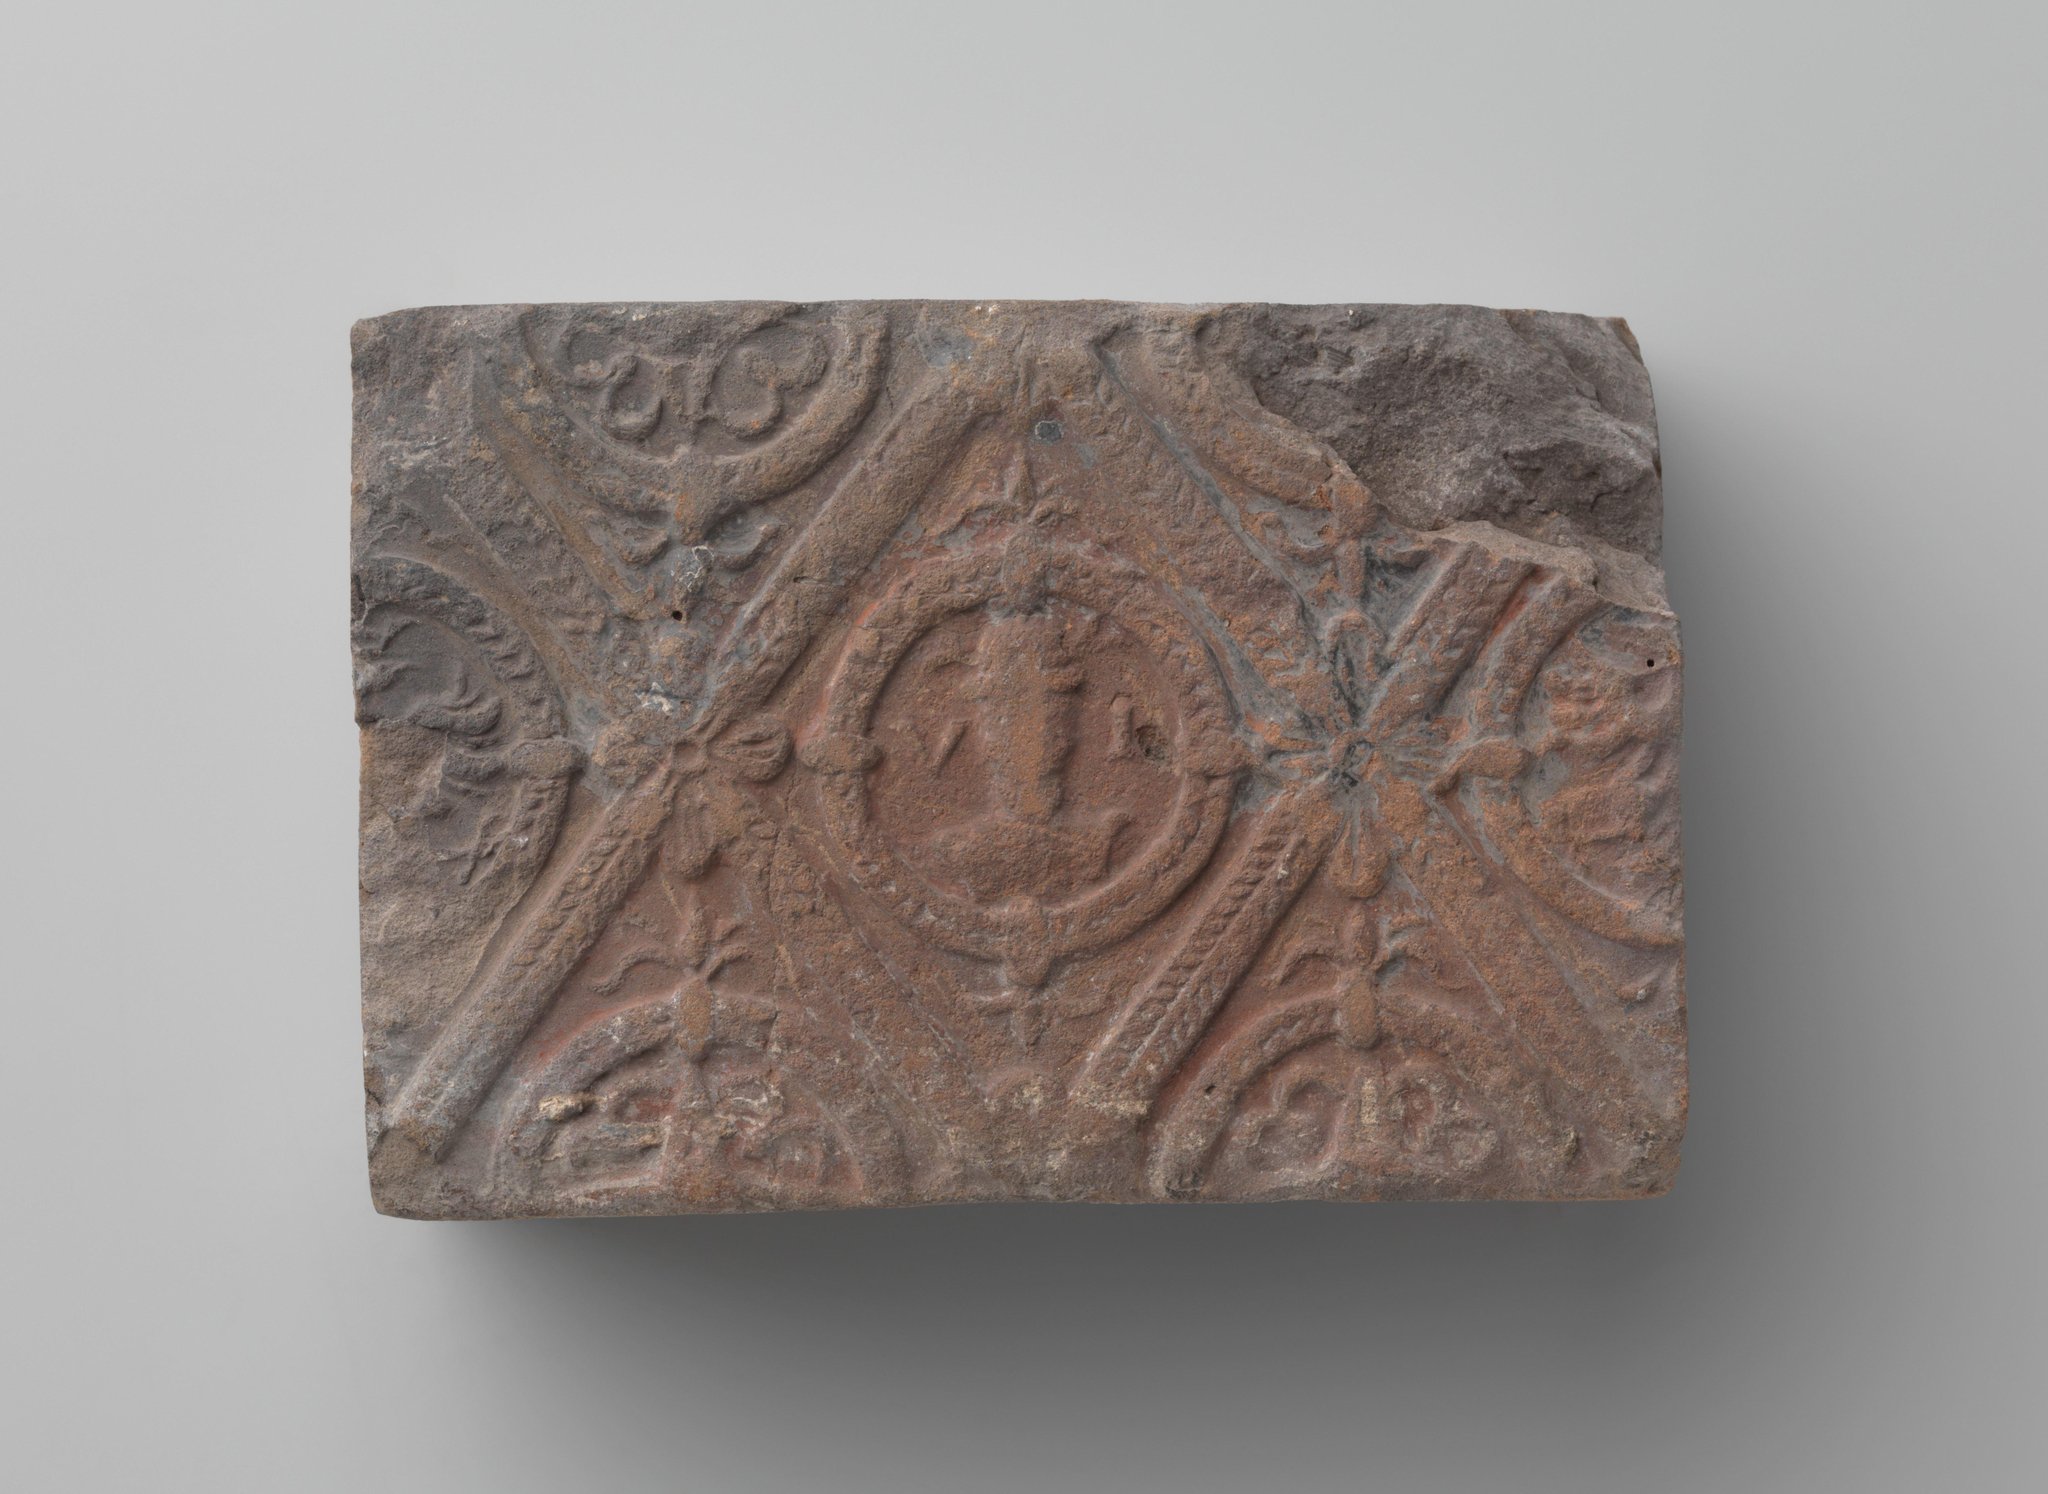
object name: hearthstone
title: Haardsteen met mannenkop en de letters V I in lauwerkrans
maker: Anonymous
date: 1575-1625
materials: earthenware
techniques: printing, firing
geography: southern netherlands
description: Haardsteen met voorstelling van mannenkop en de letters V I in lauwerkrans, geplaatst in geprofileerde ruit. In de halve ruiten aan de zijkanten een dubbelkoppige adelaar. De halve ruiten aan de boven- en onderkant zijn opgevuld met halve medaillons met stermotief.